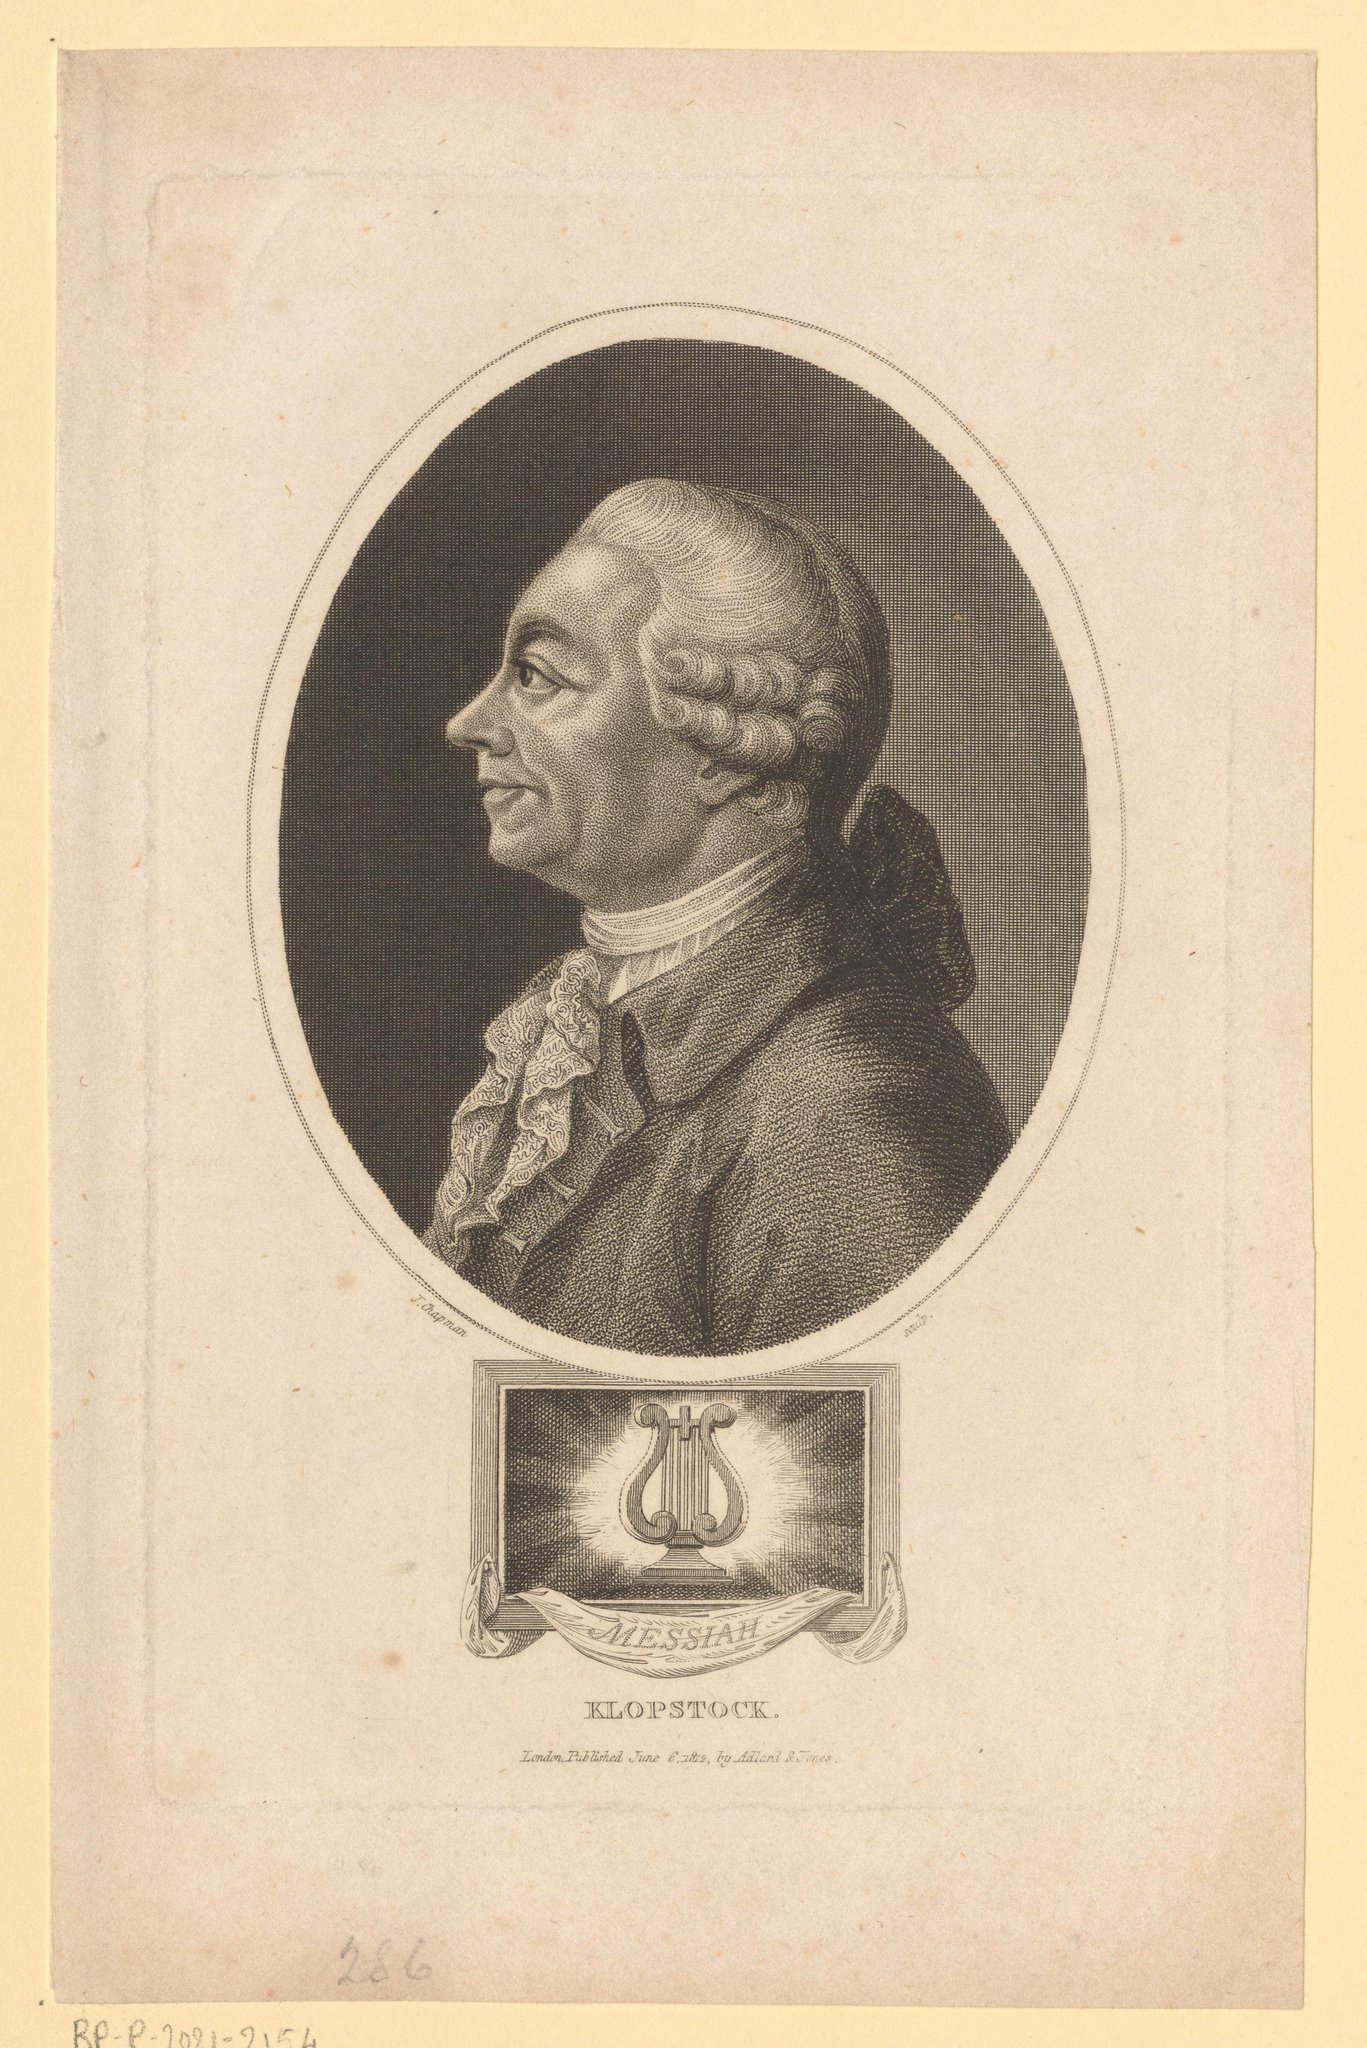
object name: print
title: Portret van Friedrich Gottlieb Klopstock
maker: john chapman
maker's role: print maker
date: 1812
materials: paper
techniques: engraving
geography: london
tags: historical persons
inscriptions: date